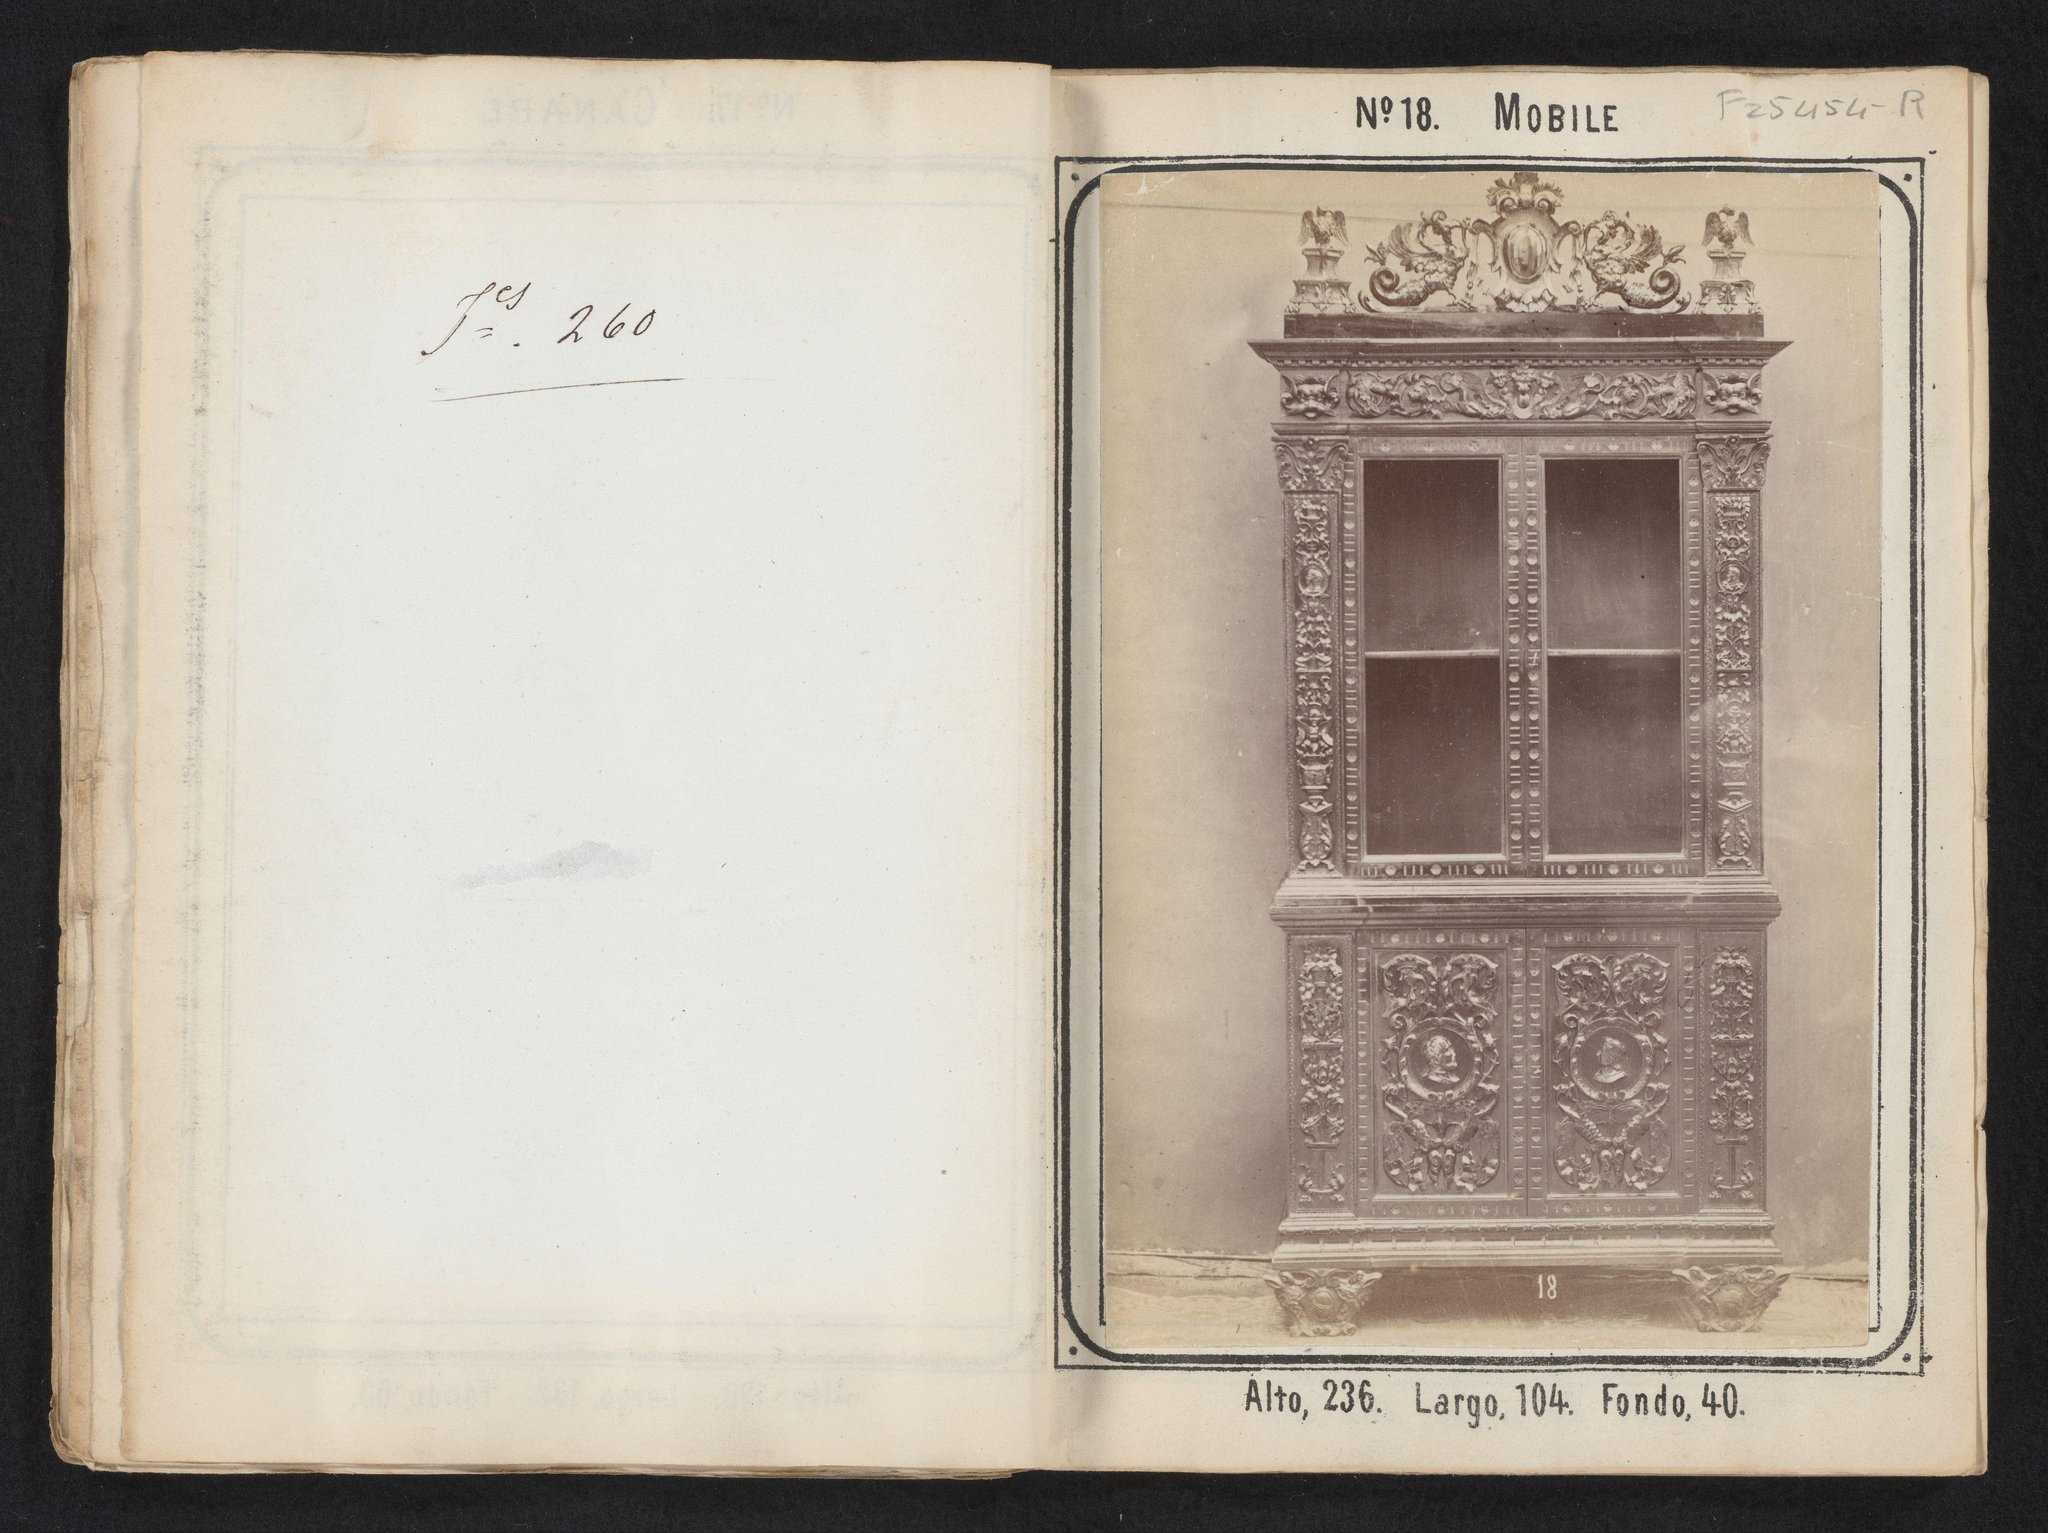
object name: photograph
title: Vitrinekast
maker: Anonymous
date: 1878-1885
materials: paper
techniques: albumen print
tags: ornamental cupboard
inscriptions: inscription: ‘Alto, 236. Largo, 104. Fondo, 40.’, inscription: ‘Ies. 280’